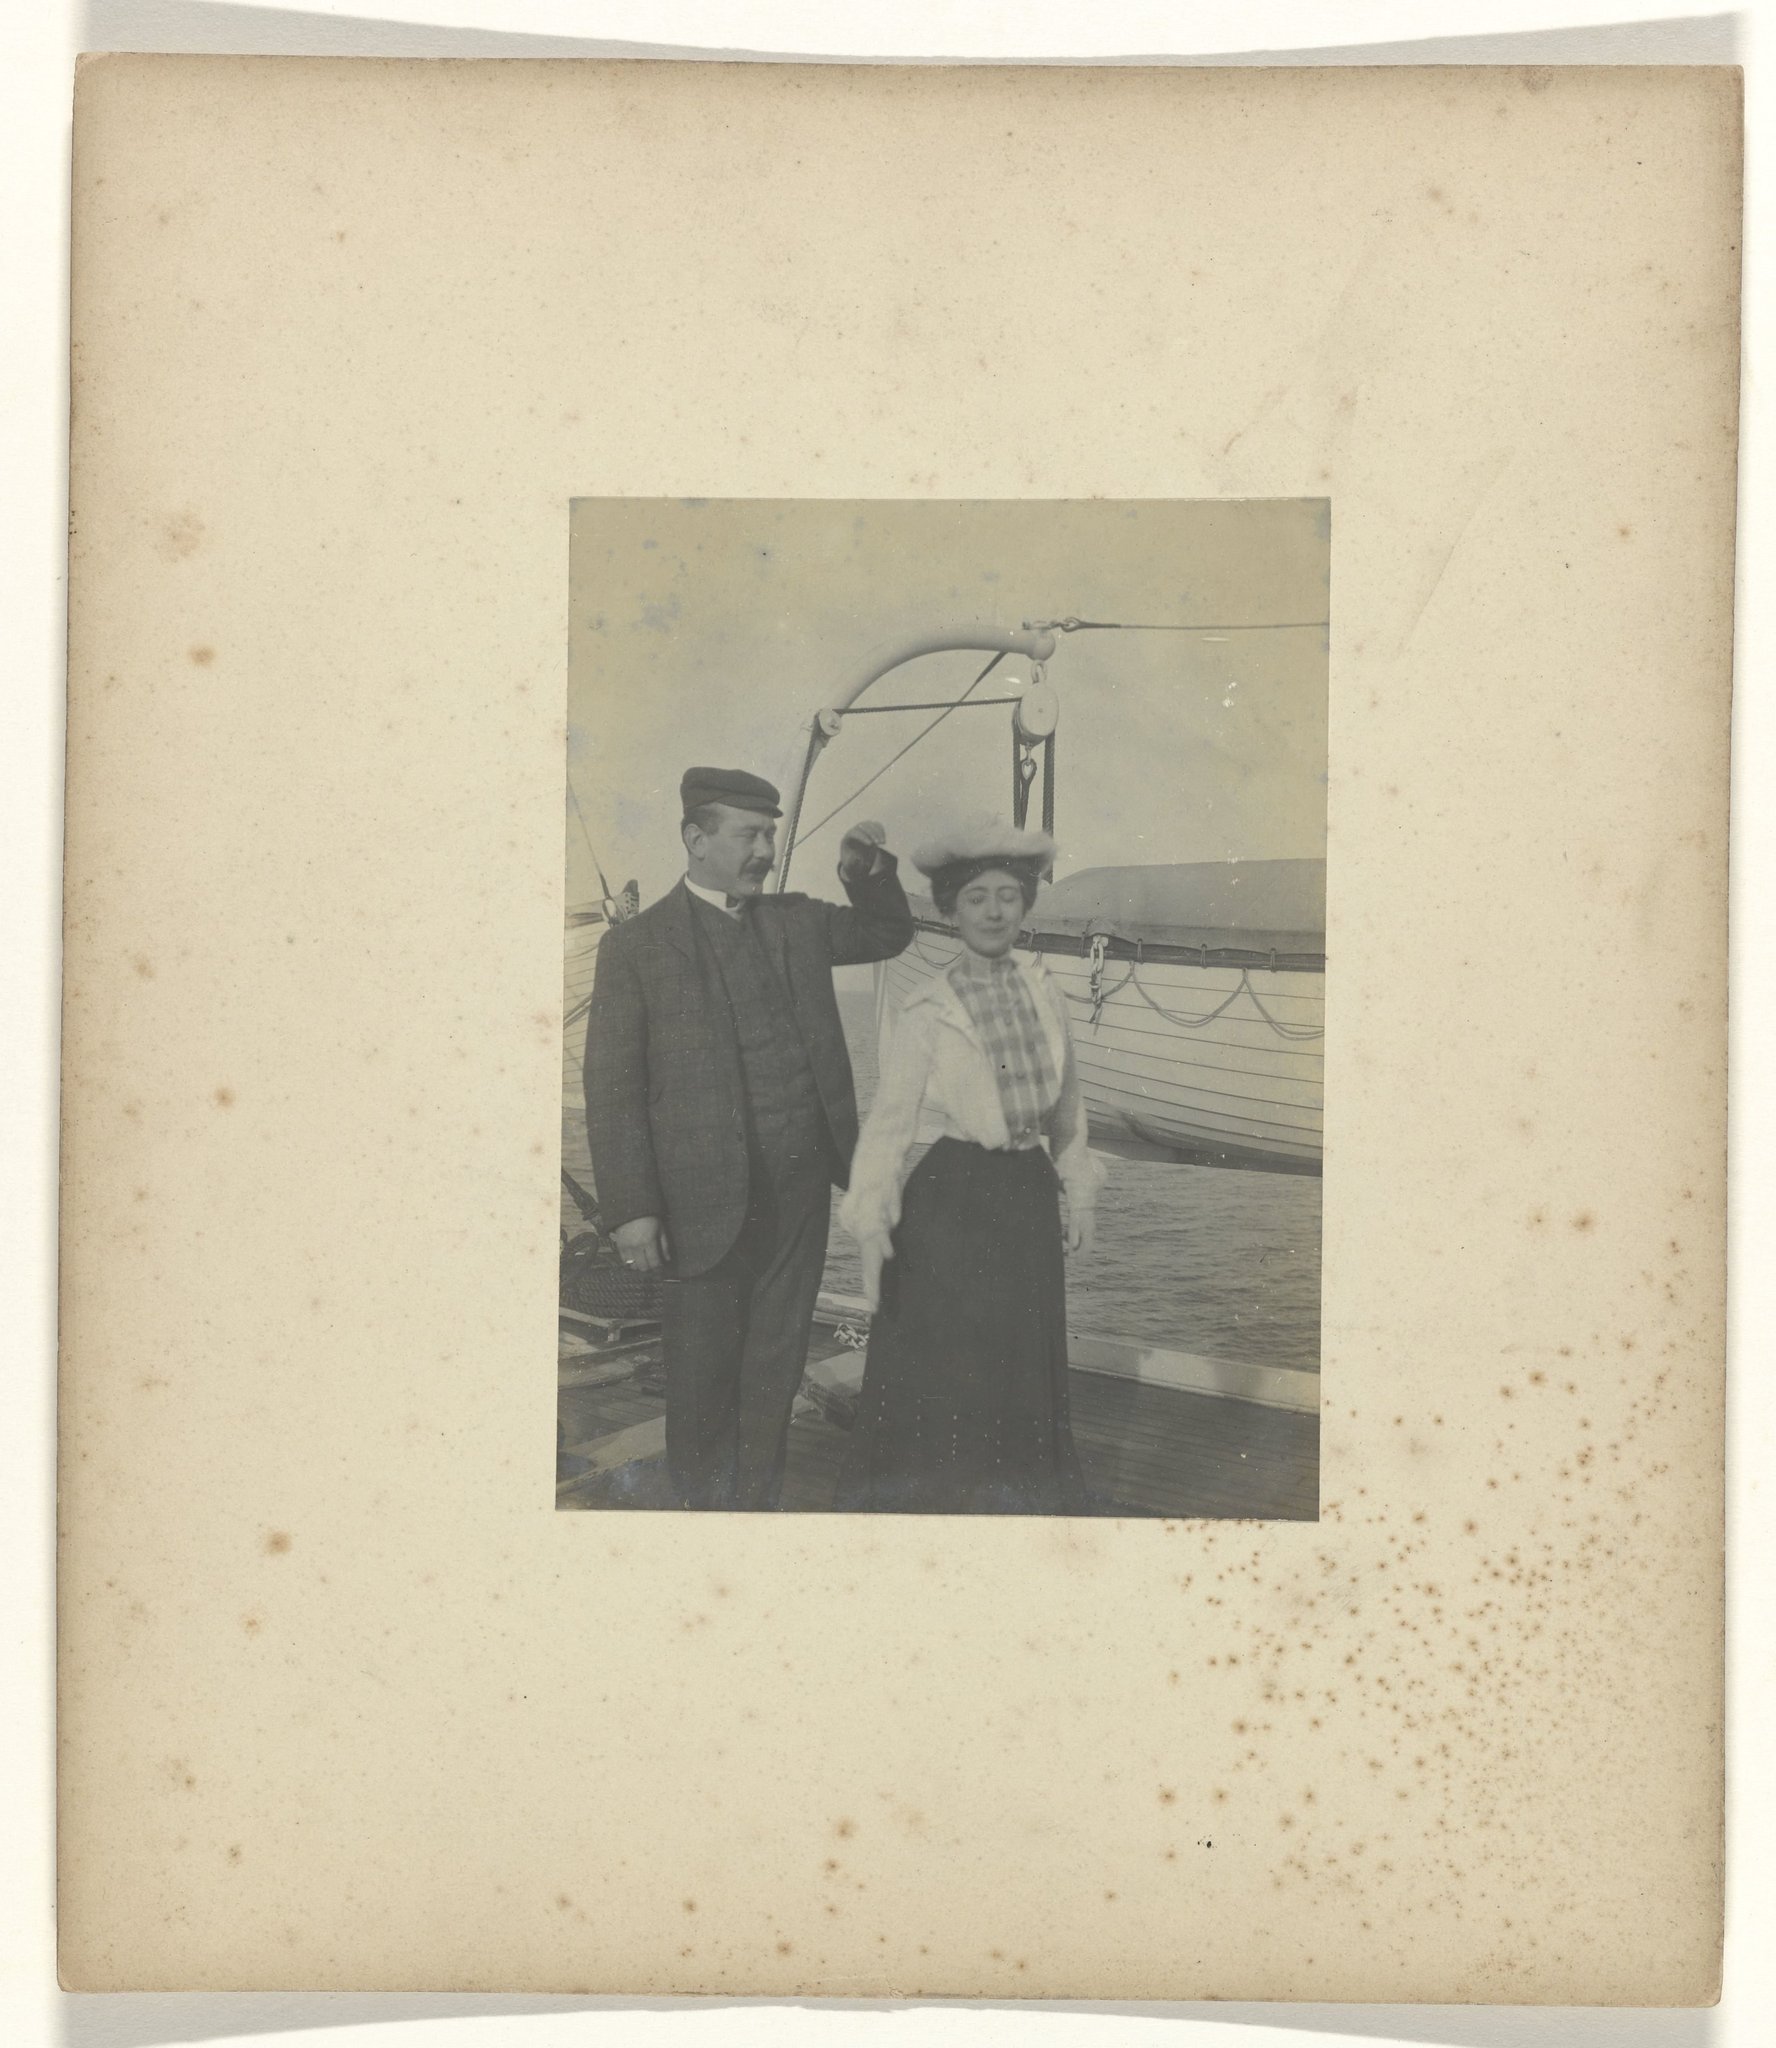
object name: photograph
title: Onbekende man en vrouw op het dek van een schip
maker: Anonymous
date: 1904-1905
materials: cardboard, paper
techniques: gelatin silver print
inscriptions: annotation: ‘?’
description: Onbekende man en vrouw op het dek van een schip.